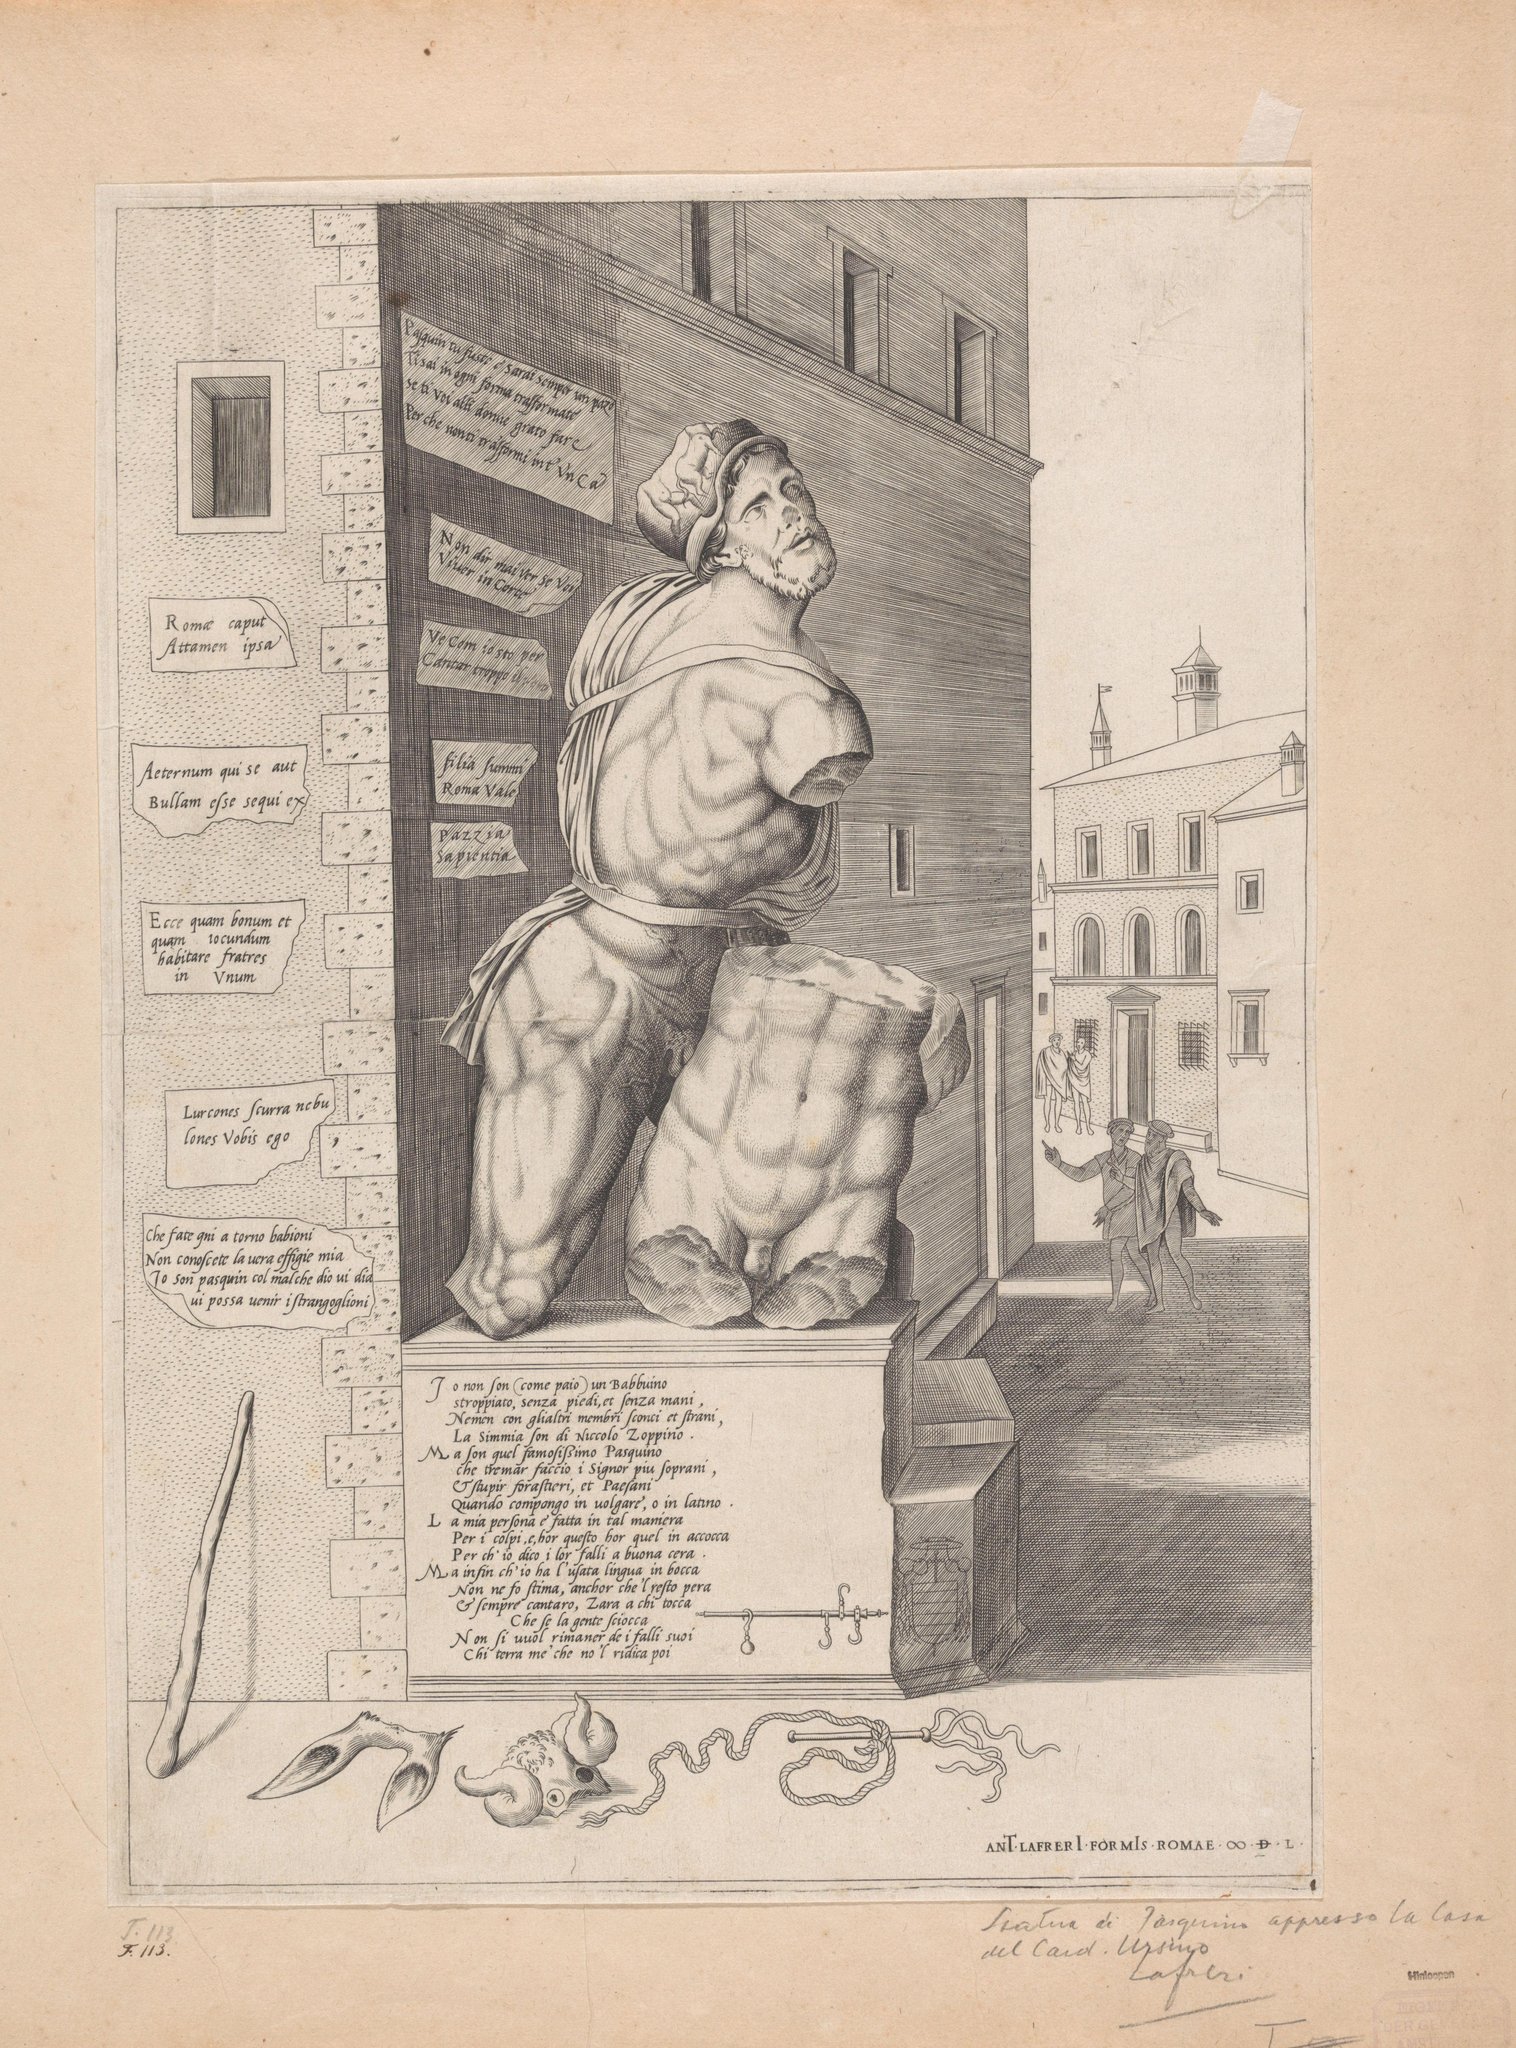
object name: print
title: Speculum Romanae Magnificentiae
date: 1550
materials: paper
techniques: engraving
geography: rome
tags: communication by means of 'statue parlanti', such as marforio and pasquino in rome, piece of sculpture, reproduction of a piece of sculpture, rome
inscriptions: collector's mark: ‘Hinloopen’, collector's mark: Lugt 11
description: Het beeld staat op het Piazza di Pasquino in Rome. Deze prent behoort tot het prentcorpus dat bekend staat als de ‘Speculum Romanae Magnificentiae’ (‘Spiegel van Romeinse pracht’). Dit corpus, bestaande uit prenten met voorstellingen van kunstwerken en gebouwen uit het antieke en het moderne Rome, vond zijn oorsprong bij uitgevers Antonio Salamanca en Antonio Lafreri. Deze twee buitenlandse uitgevers bundelden hun krachten te Rome in de periode 1553-1563. Hun prenten werden al snel razend populair bij toeristen en verzamelaars, die de prenten individueel of in grote groepen aanschaften. Grote groepen Speculum-prenten werden vaak op aanvraag samengebonden in albums. Er zijn verschillende Speculum-albums overgeleverd die allemaal verschillen van inhoud. Tussen 1573 en 1577 gaf Antonio Lafreri een speciale titelpagina uit (met de titel ‘Speculum Romanae Magnificentiae’) die mensen voor hun verzamelingen konden voegen. Het overlijden van Lafreri in 1577 betekende niet het einde van het corpus. Een groot deel van de koperplaten ging over op Claudio en Stefano Duchetti. De rest raakte verspreid over verschillende andere uitgevers. De populariteit van de Speculum-prenten wist nog geruime periode uitgevers te inspireren tot het laten maken van kopieën en het toevoegen van nieuwe prenten aan het corpus.